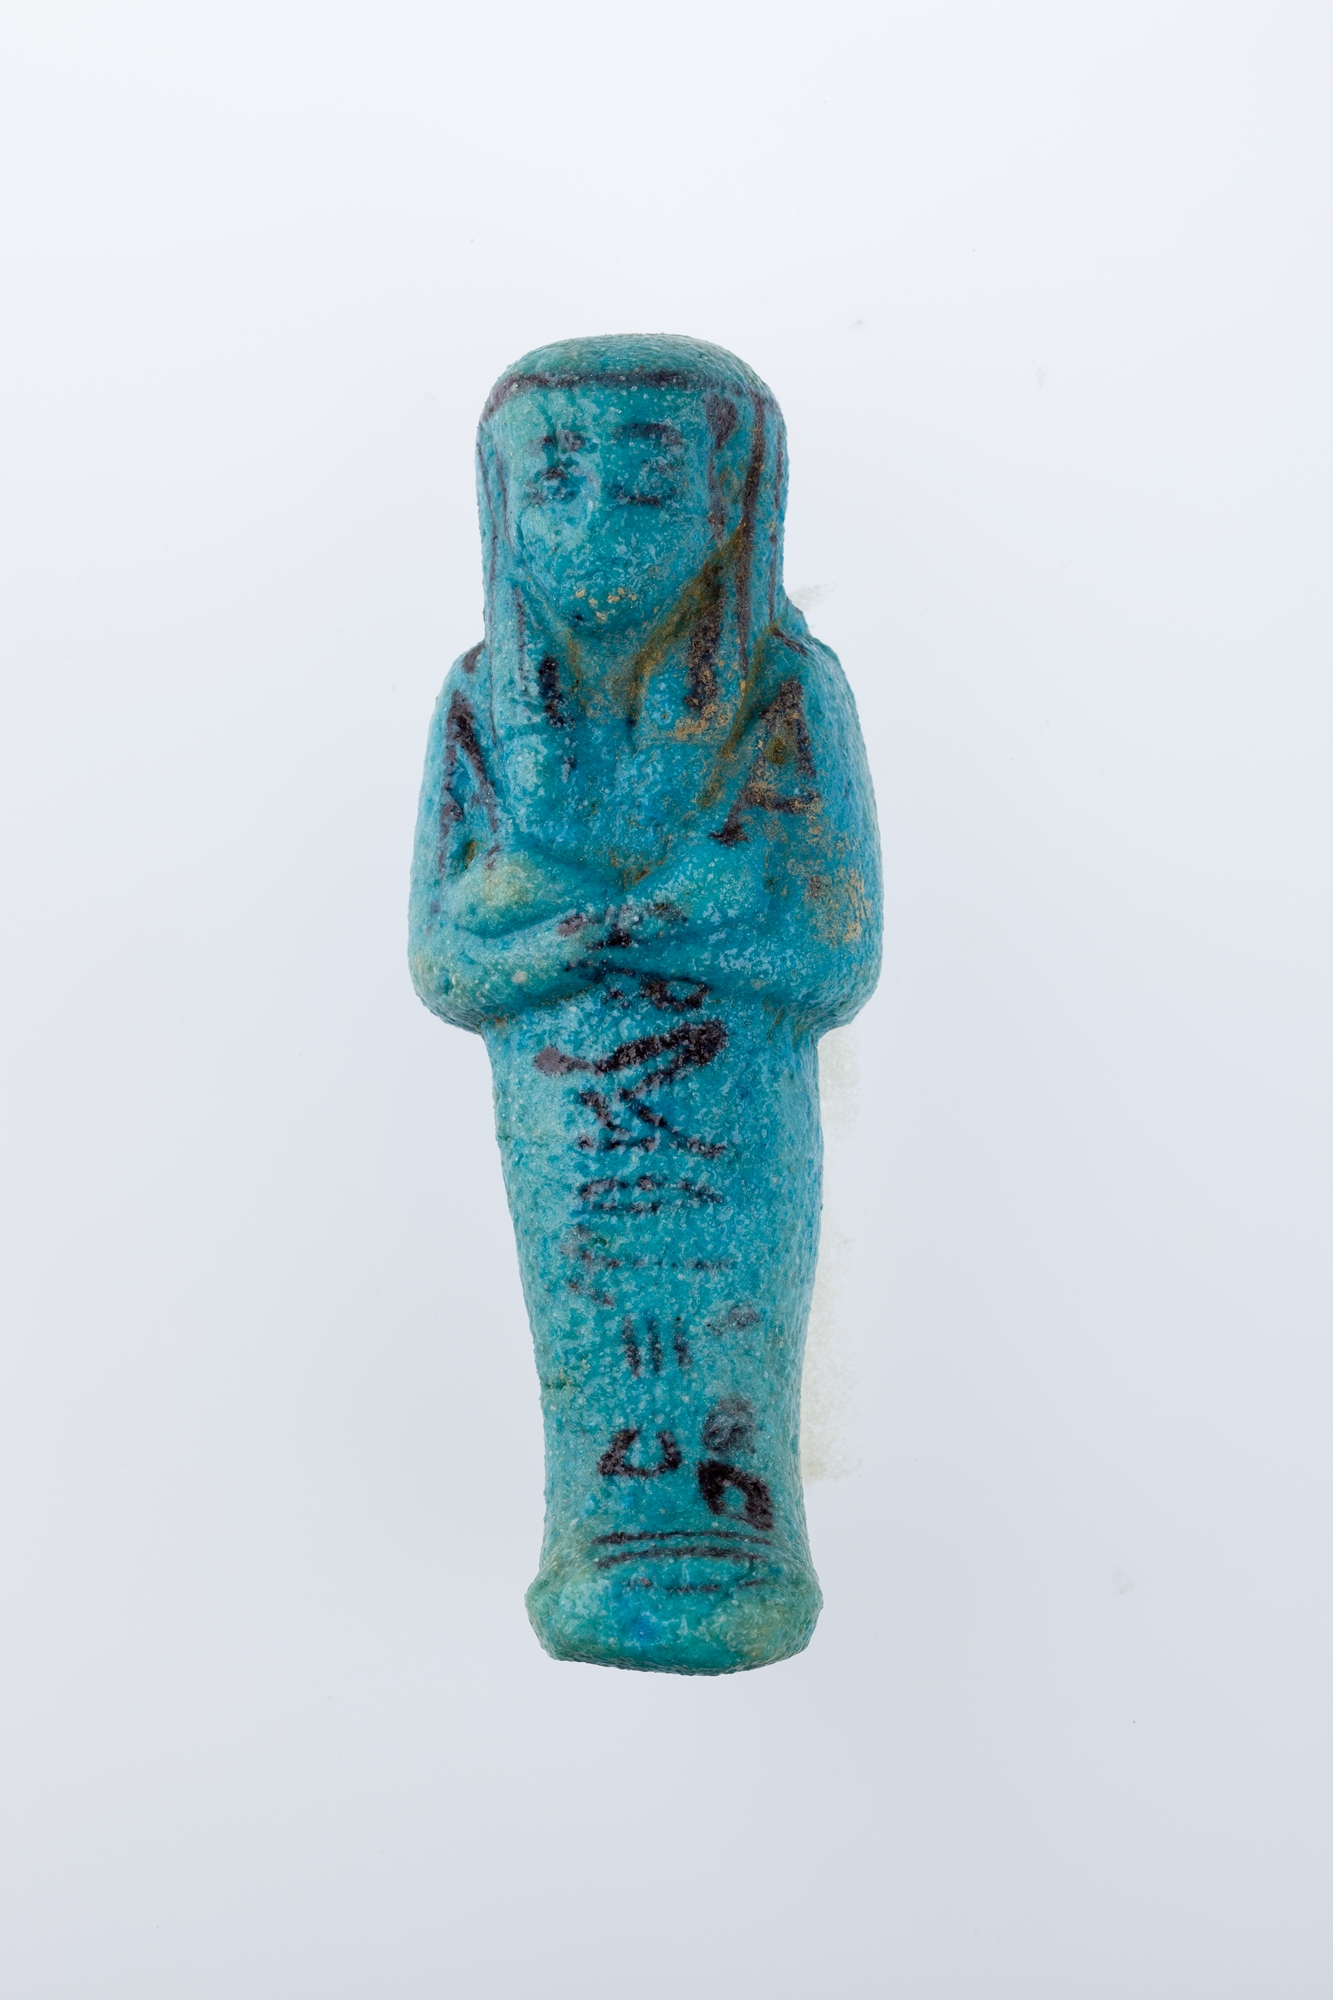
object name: shabti, henettawy c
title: Worker Shabti of Henettawy (C), Daughter of Isetemkheb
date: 990-970 BCE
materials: faience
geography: egypt